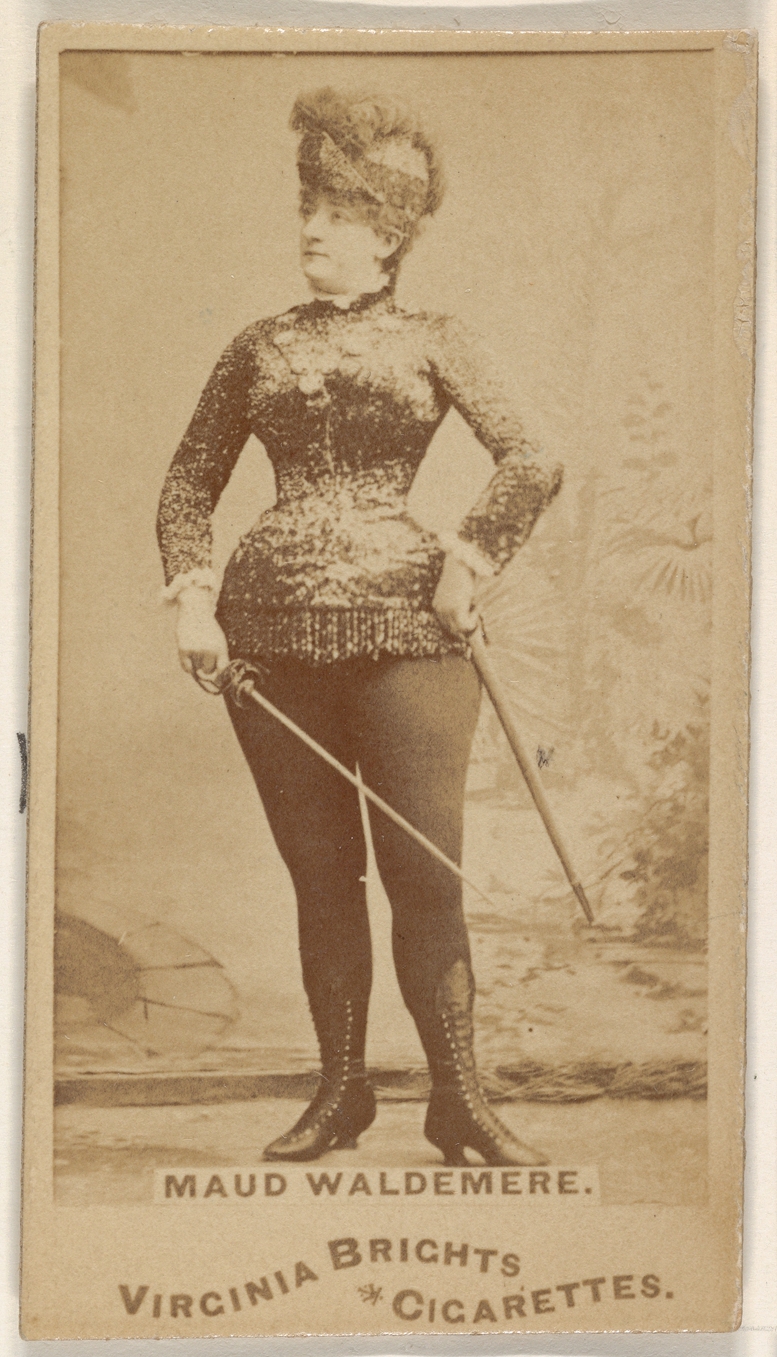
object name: photograph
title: Maud Waldemere, from the Actors and Actresses series (N45, Type 1) for Virginia Brights Cigarettes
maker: allen & ginter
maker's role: publisher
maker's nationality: american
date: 1888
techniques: albumen silver print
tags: portraits,women,actresses